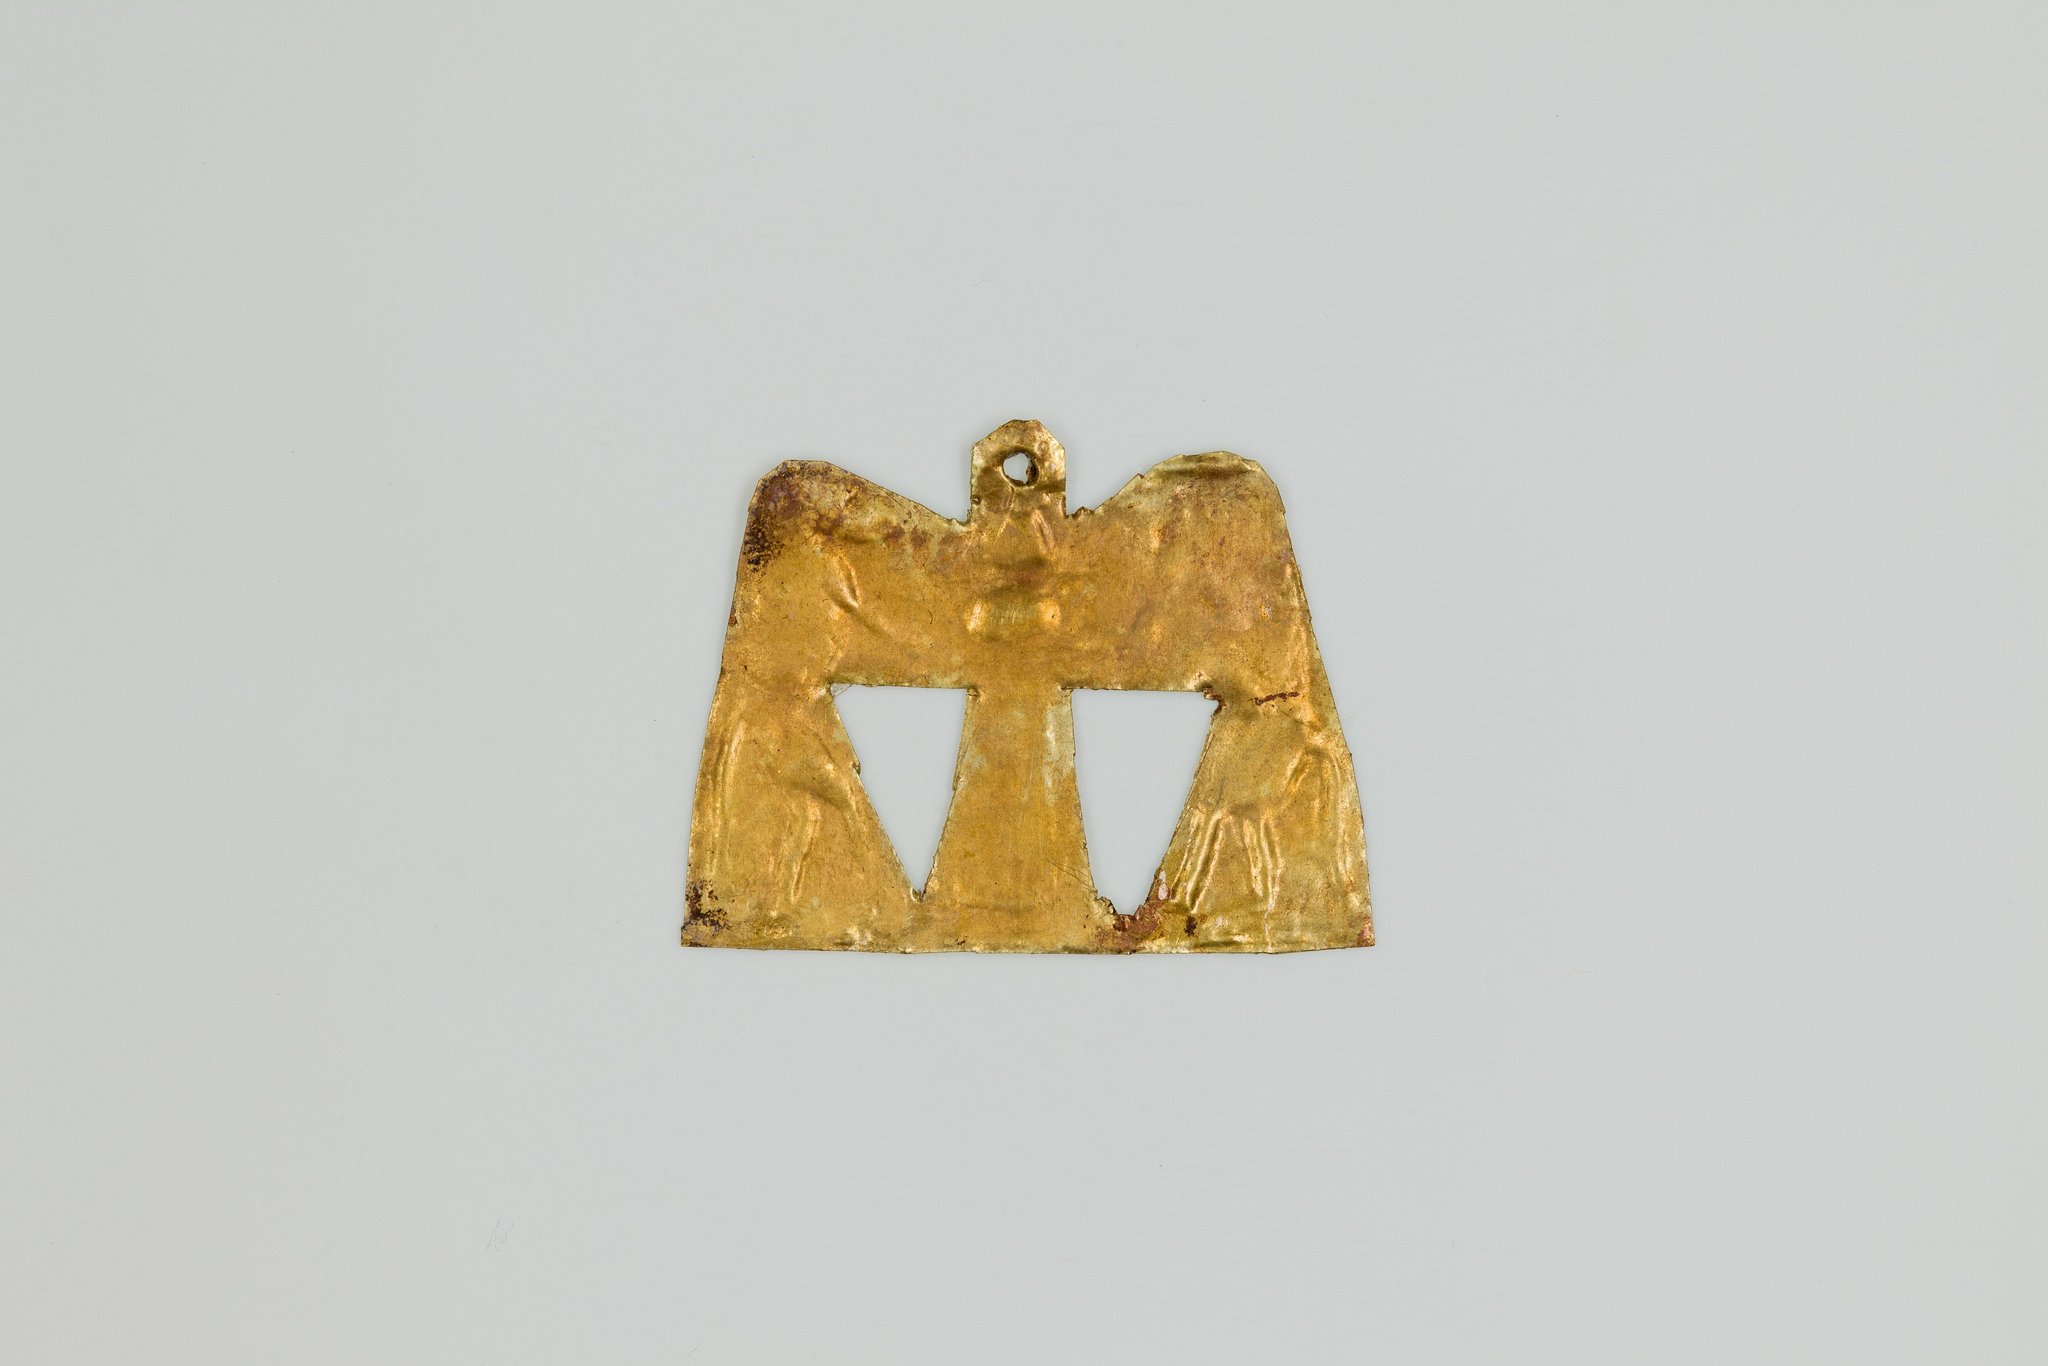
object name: amulet, baboon, djed pillar, sundisk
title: Amulet depicting two baboons flanking a djed pillar with sundisk and atef-crown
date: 664-380 BCE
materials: gold